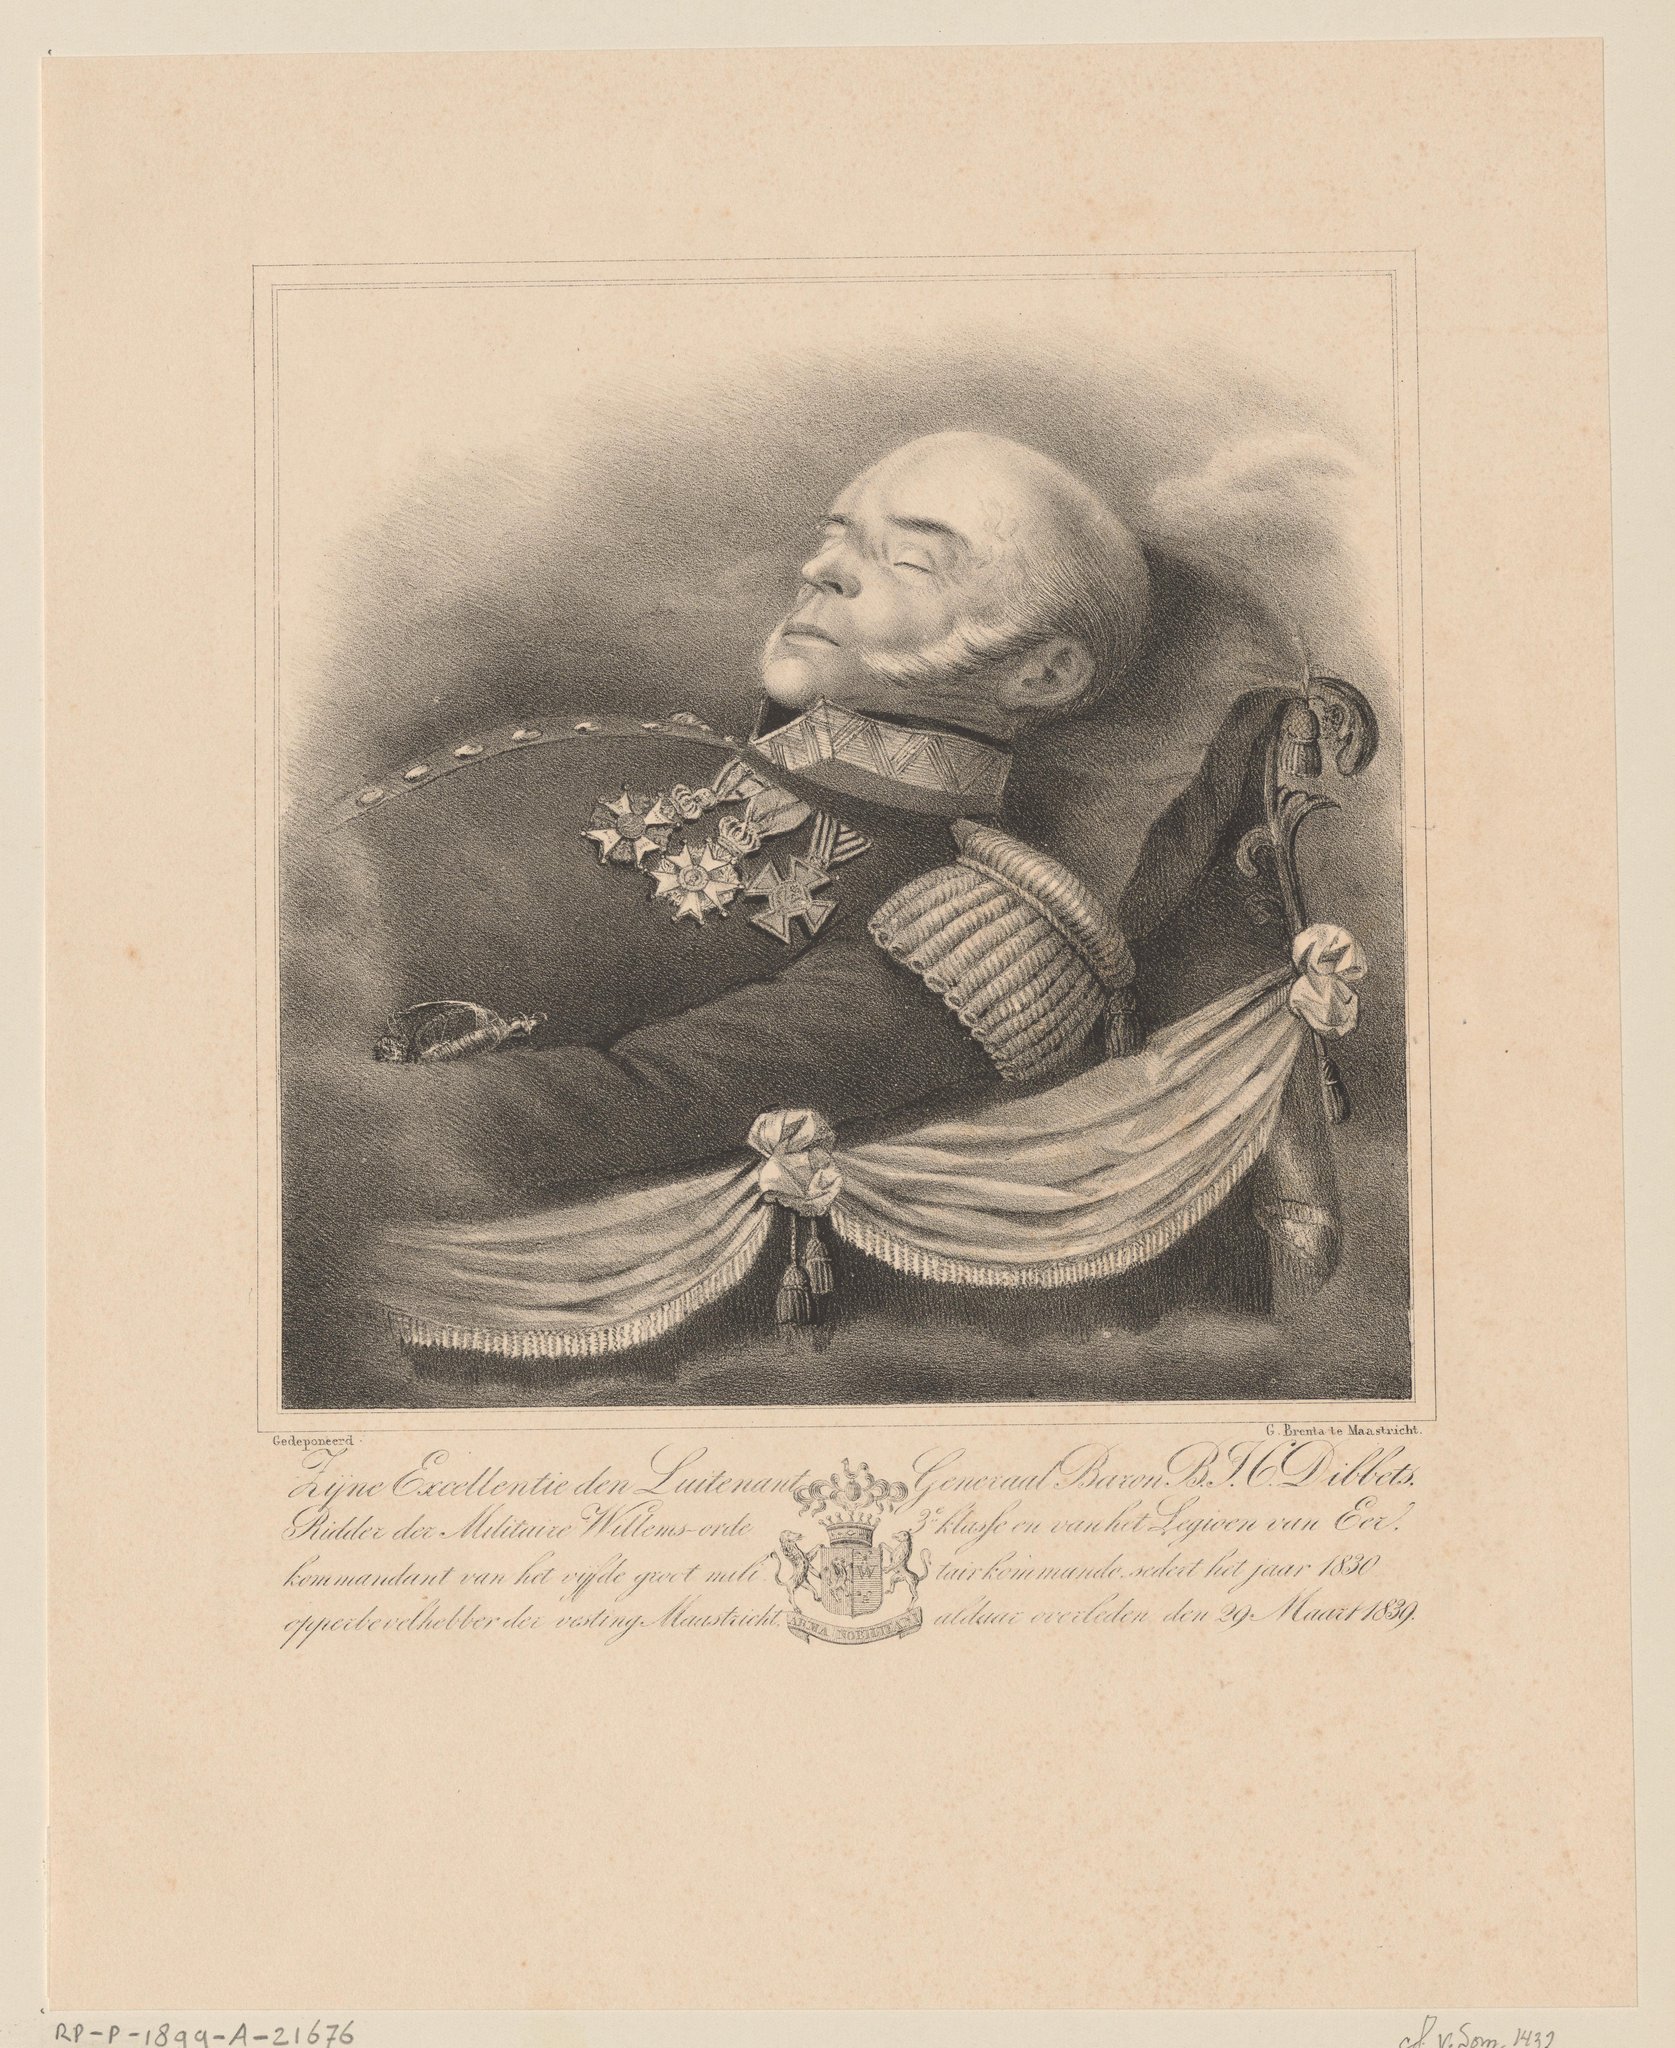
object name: print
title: Portret van baron Bernardus Johannes Cornelis Dibbets op zijn sterfbed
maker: gerardus antonius josephus brenta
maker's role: print maker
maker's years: 1807-1853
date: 1839-1853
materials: paper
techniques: lithograph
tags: maastricht, commander-in-chief, general, marshal, deathbed, historical persons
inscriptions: collector's mark: Lugt 2228